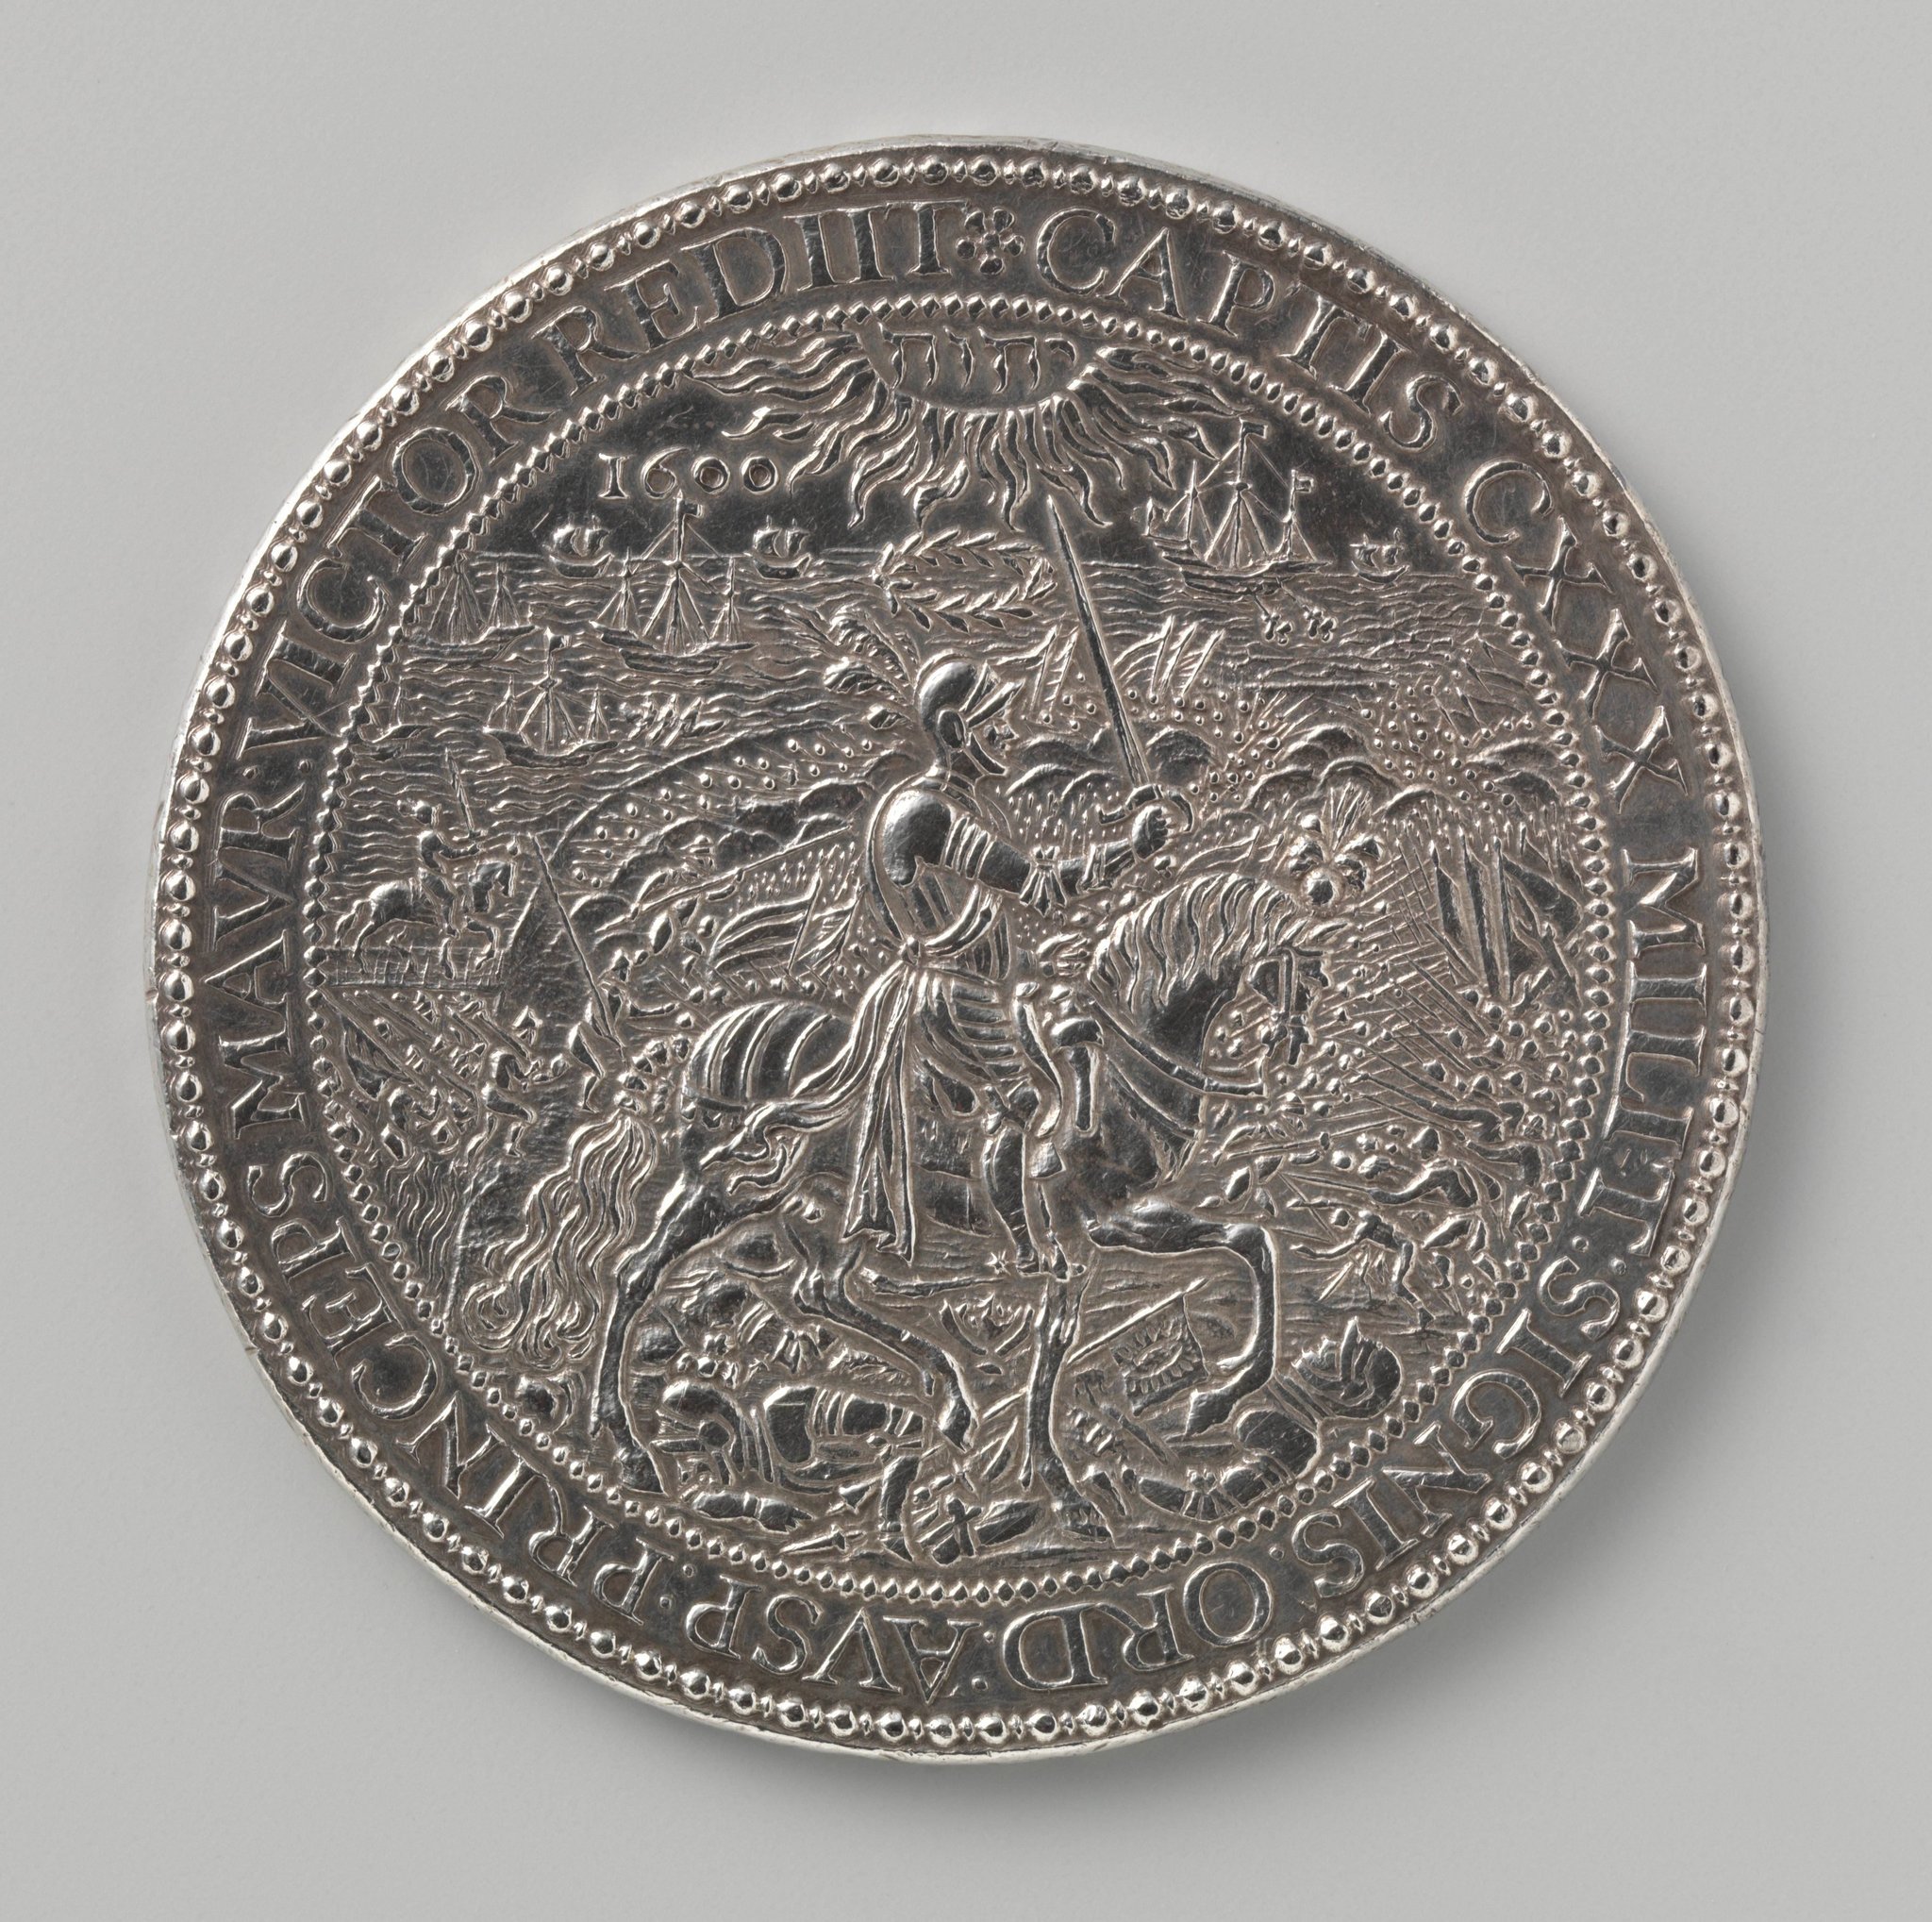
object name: triomfpenning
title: Battle of Nieuwpoort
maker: gerard van bylaer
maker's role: die cutter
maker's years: 1540-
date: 1600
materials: silver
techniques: striking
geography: dordrecht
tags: riding a horse, ass, or mule; rider, horseman, battle, battle of nieuwpoort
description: Commemorating Dutch liberty. Many medals were made to commemorate important events or people. The Dutch revolt against the Spanish king that began in 1568 and the ups and downs of the independent Dutch Republic, which existed from 1588, were ample reasons for striking medals.